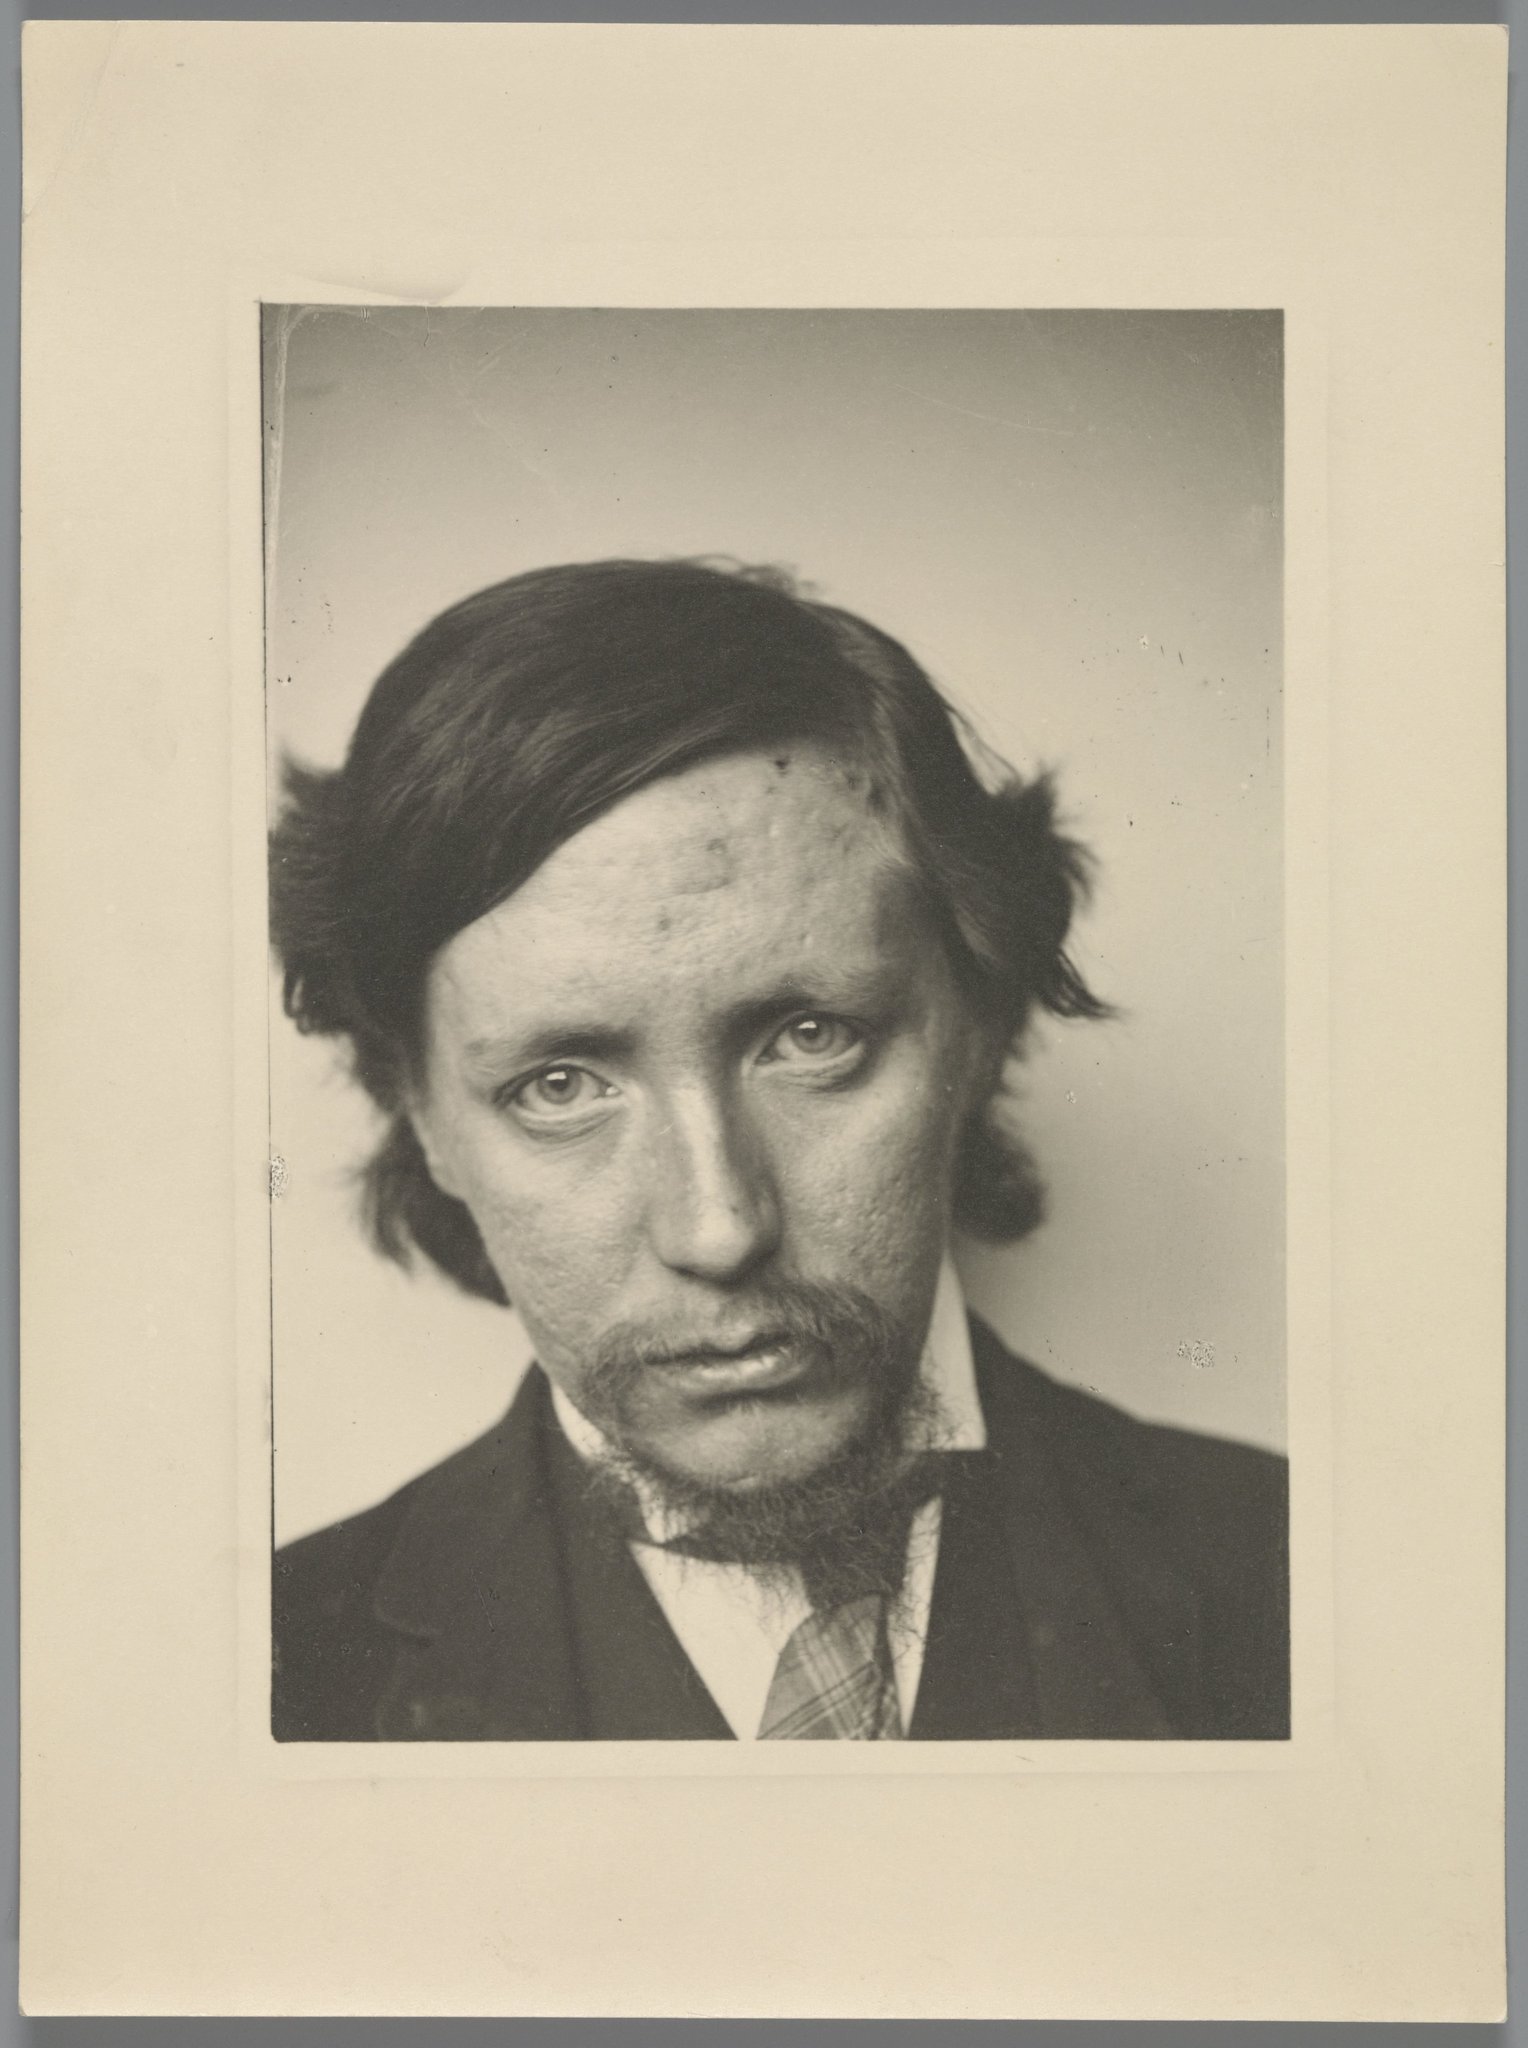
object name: photograph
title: Reproductie naar een foto van Willem Witsen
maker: Anonymous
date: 1860-1915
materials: paper, photographic support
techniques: gelatin silver print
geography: netherlands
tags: amsterdam, the hague, willem kloos